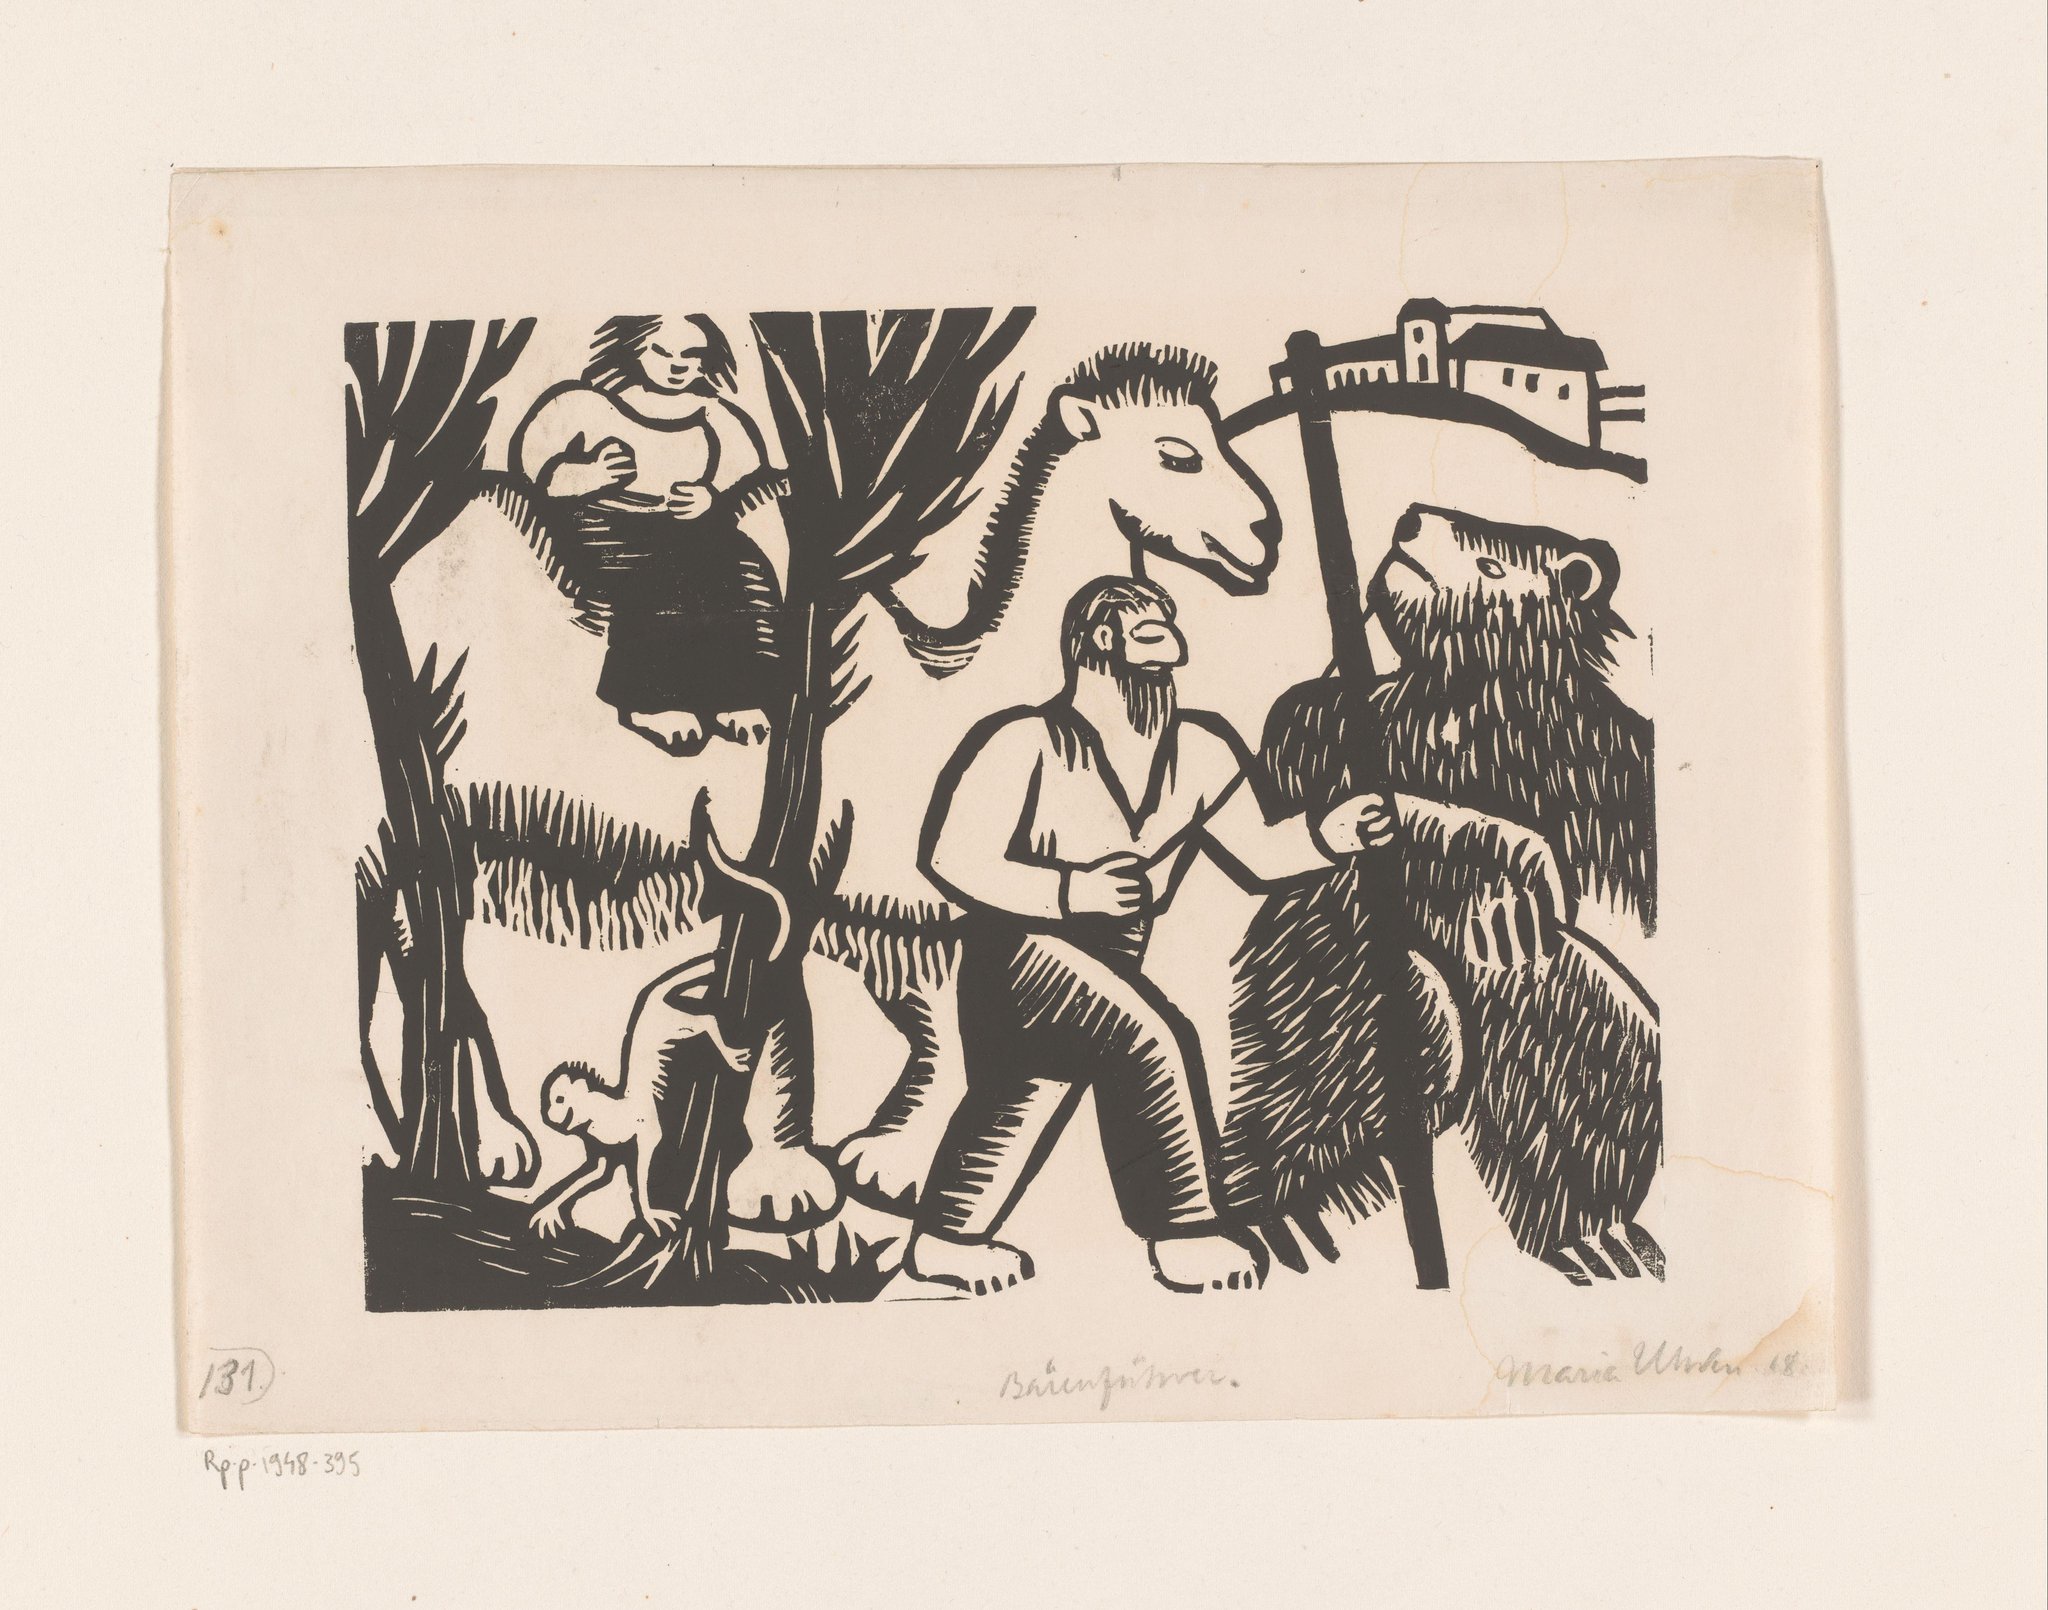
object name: print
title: Bärenführer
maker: maria uhden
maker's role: print maker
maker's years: 1892-1918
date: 1902-1918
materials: paper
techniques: woodcut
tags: hoofed animals: camel, beasts of prey, predatory animals: bear, 'en route', traveller under way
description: Wandelende man met een beer aan een koord, daarachter een vrouw met kind op een kameel.